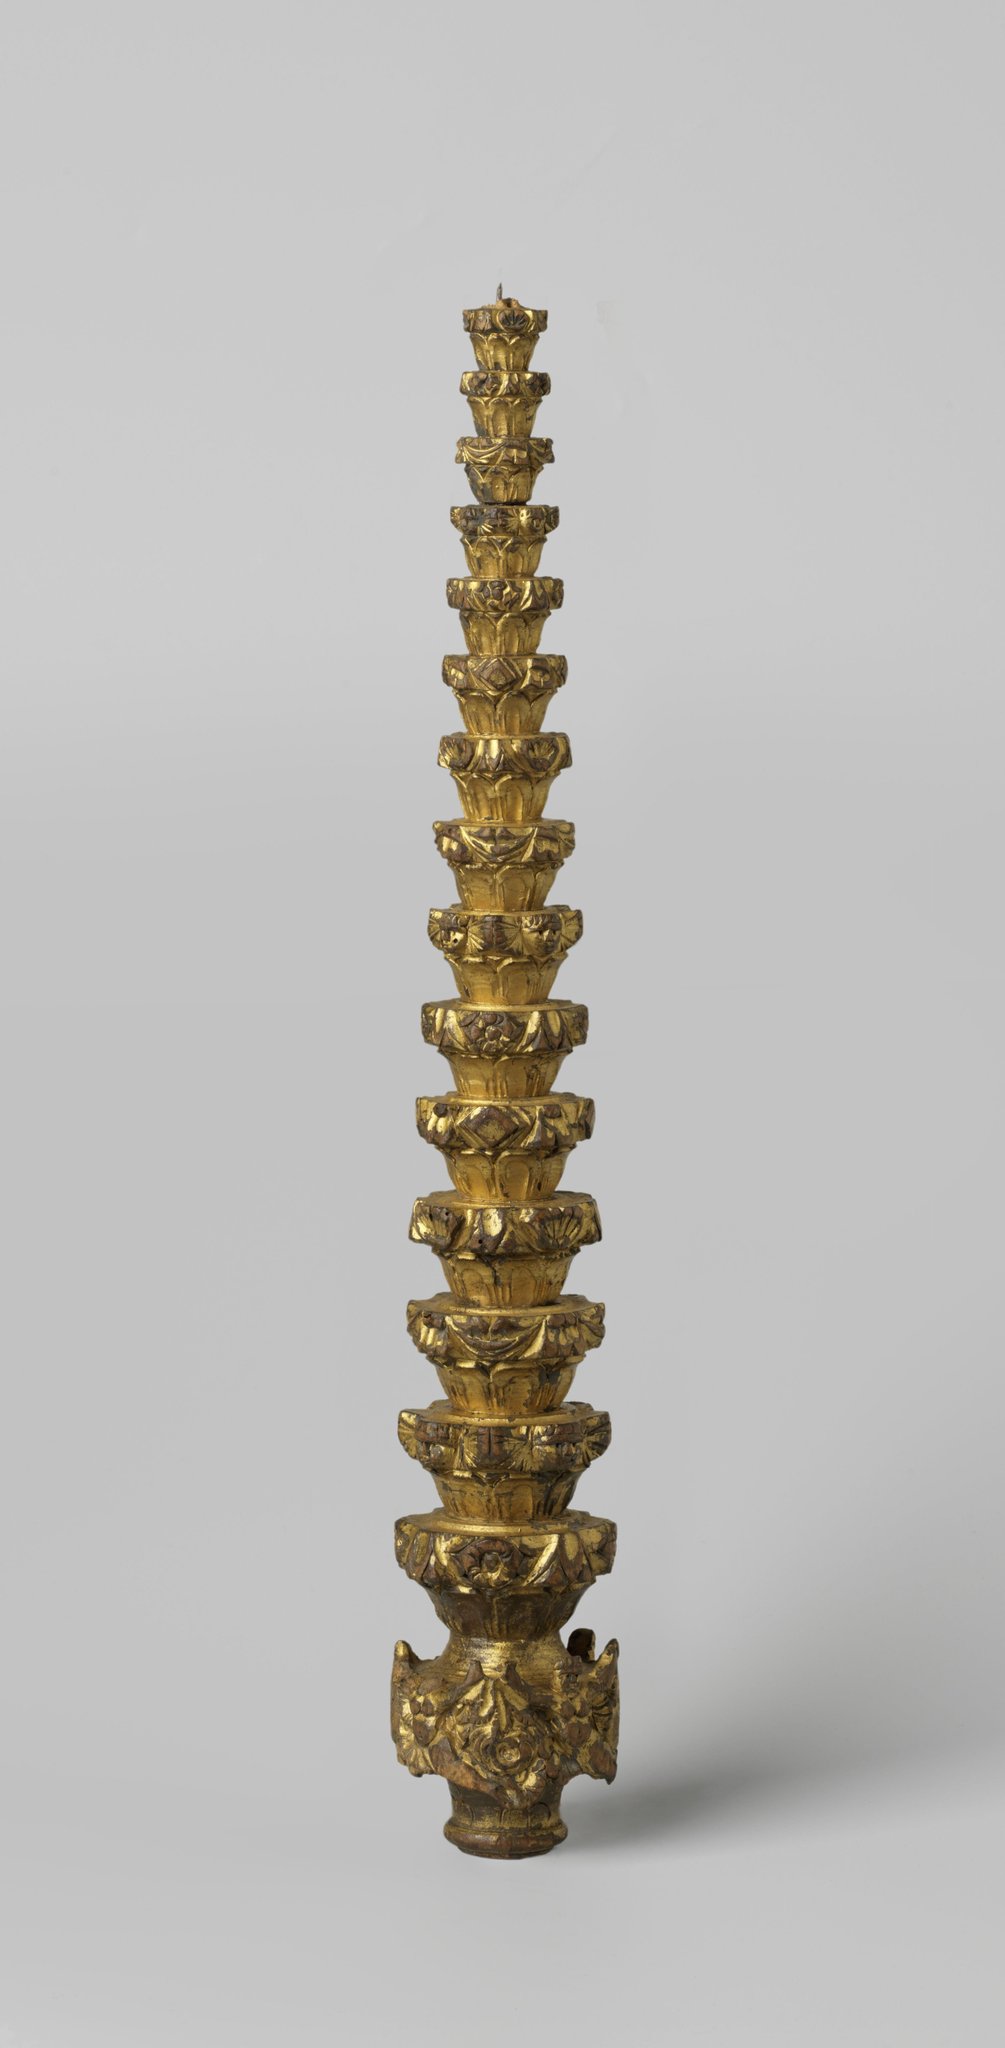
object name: mastwortel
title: Wortel van een vlaggenstok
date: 1700-1800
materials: iron, wood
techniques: cutting, gilding, turning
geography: netherlands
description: Vergulde wortel met 16 geledingen. Op de beschadigde onderste geleding vier putti met de armen omhoog. De anderen met gestileerde plantmotieven. De derde, achtste en dertiende geleding voorzien van vier kopjes. Onderin een rond gat; bovenaan bekroning afgebroken, waardoor een ijzeren pin zichtbaar is geworden.